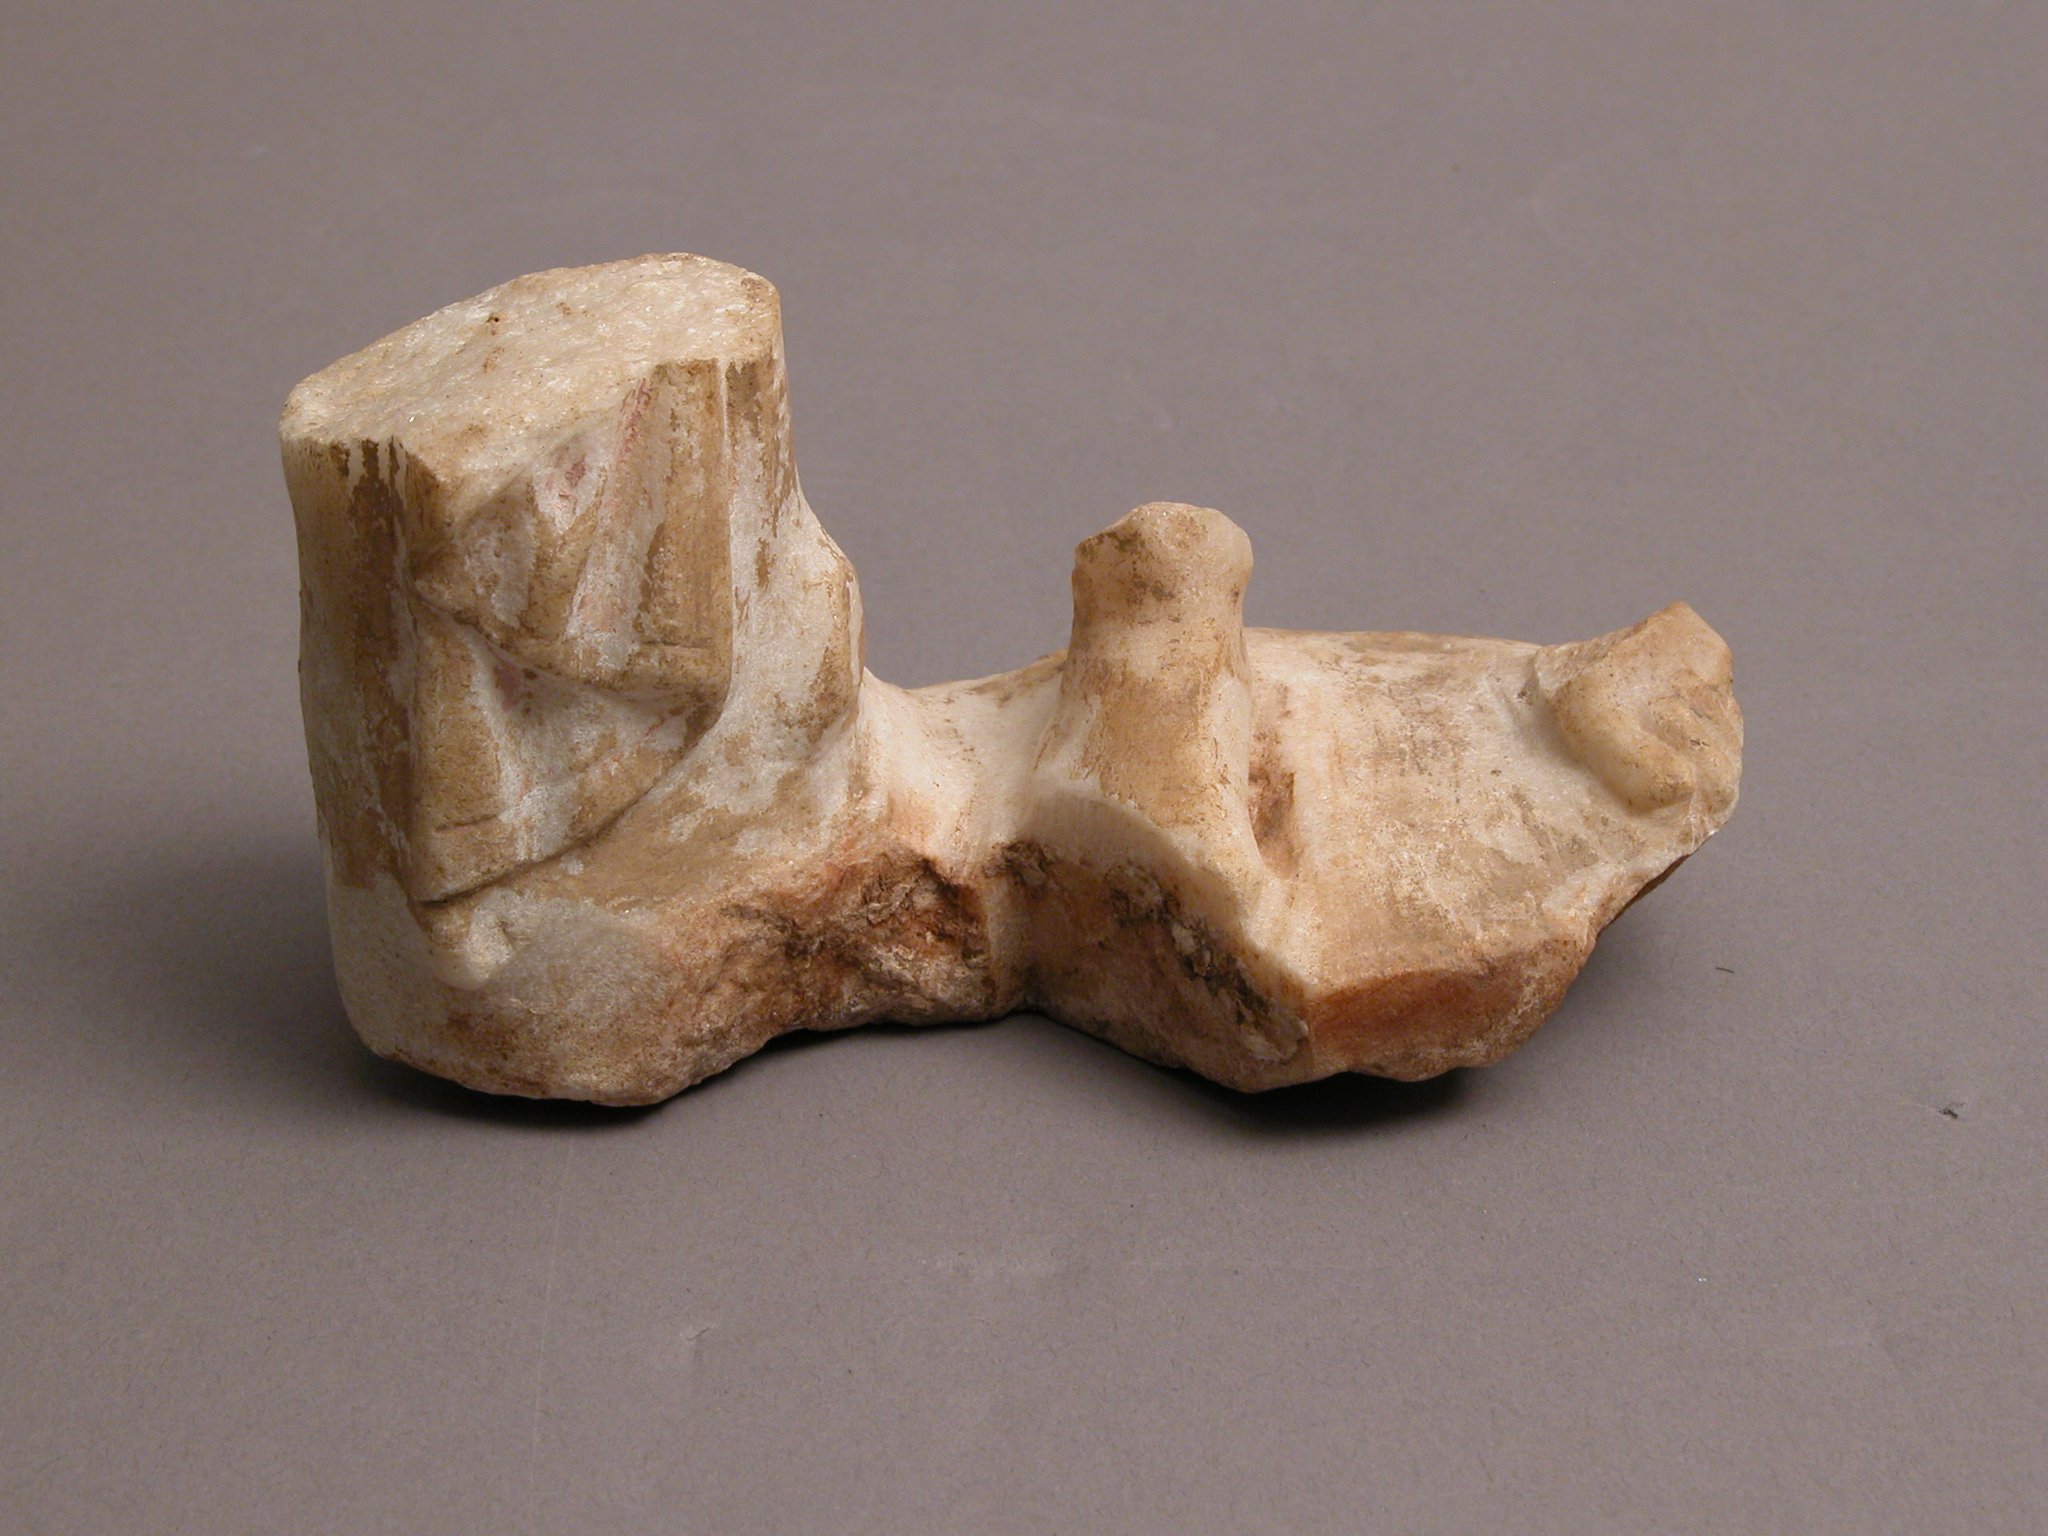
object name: statuette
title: Feet Fragment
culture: coptic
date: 301-700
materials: stone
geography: egypt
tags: feet